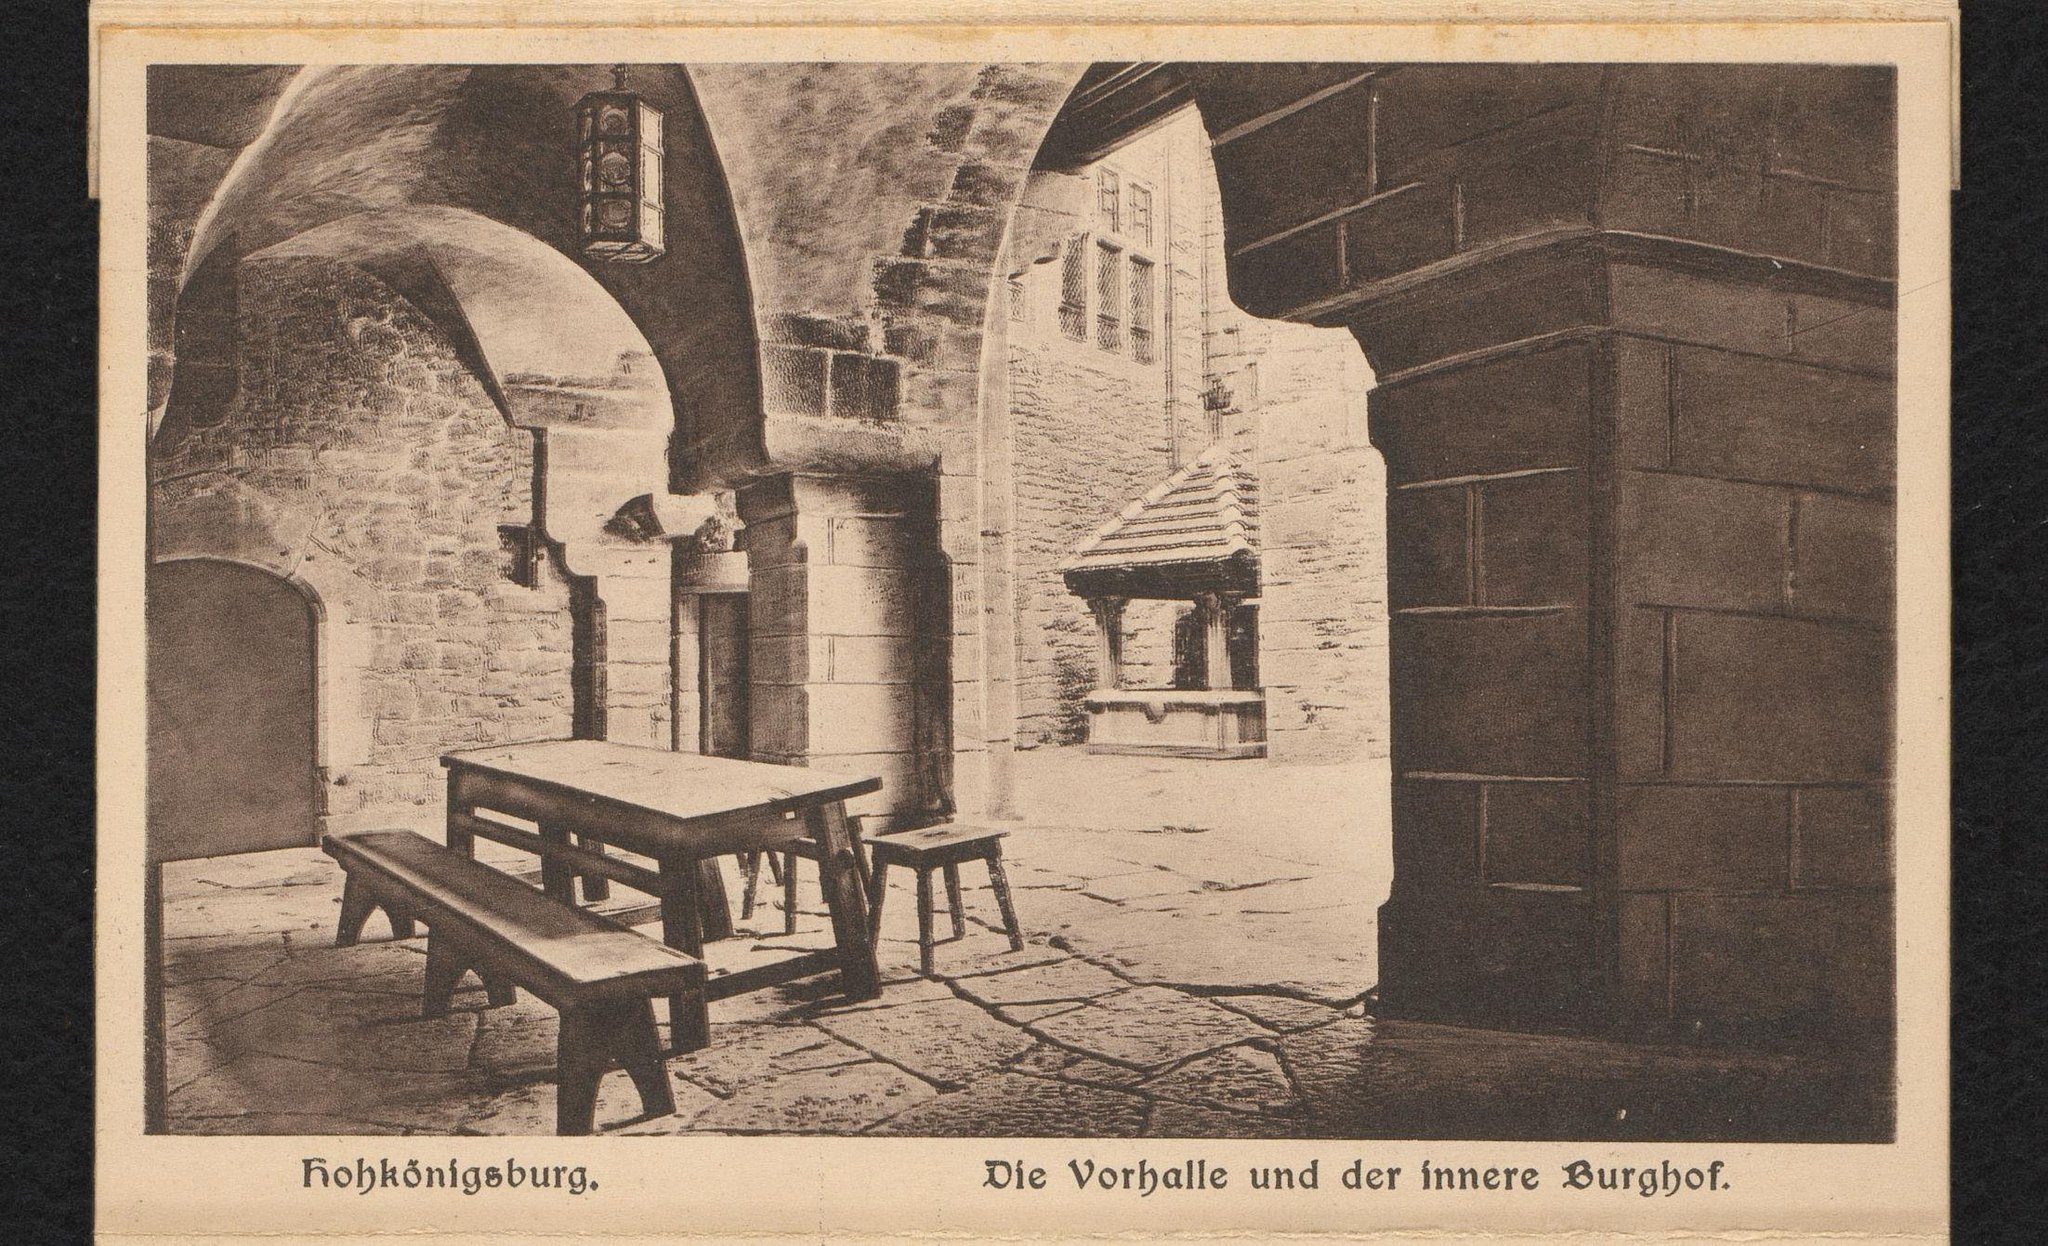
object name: photomechanical print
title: Hohkönigsburg. Die Vorhalle und der innere Burghof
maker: Anonymous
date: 1908-1913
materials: cardboard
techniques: photograph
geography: alsace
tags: castle, vestibule, hall